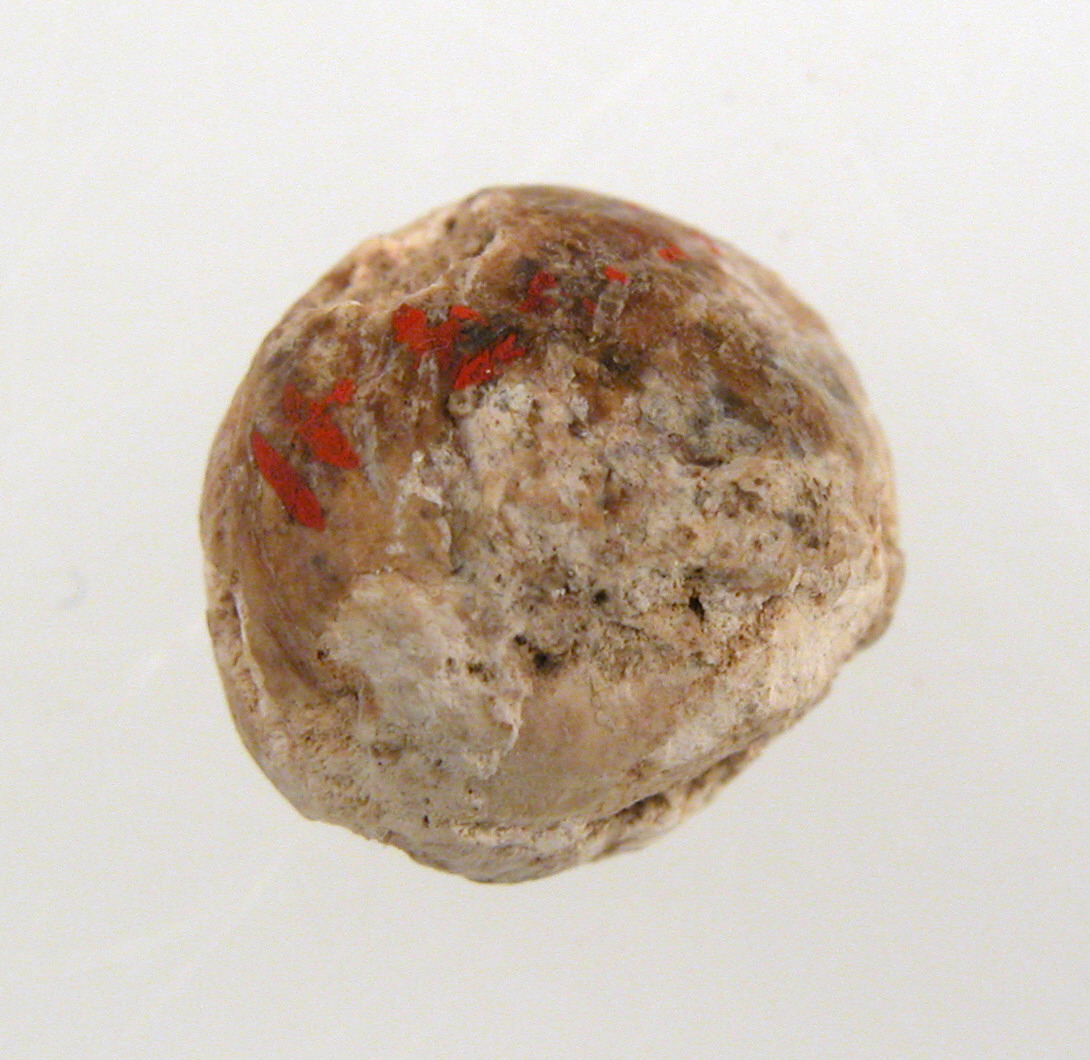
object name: cherry stone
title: Cherry Stone from a Tomb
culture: frankish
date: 500-600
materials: stone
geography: germany